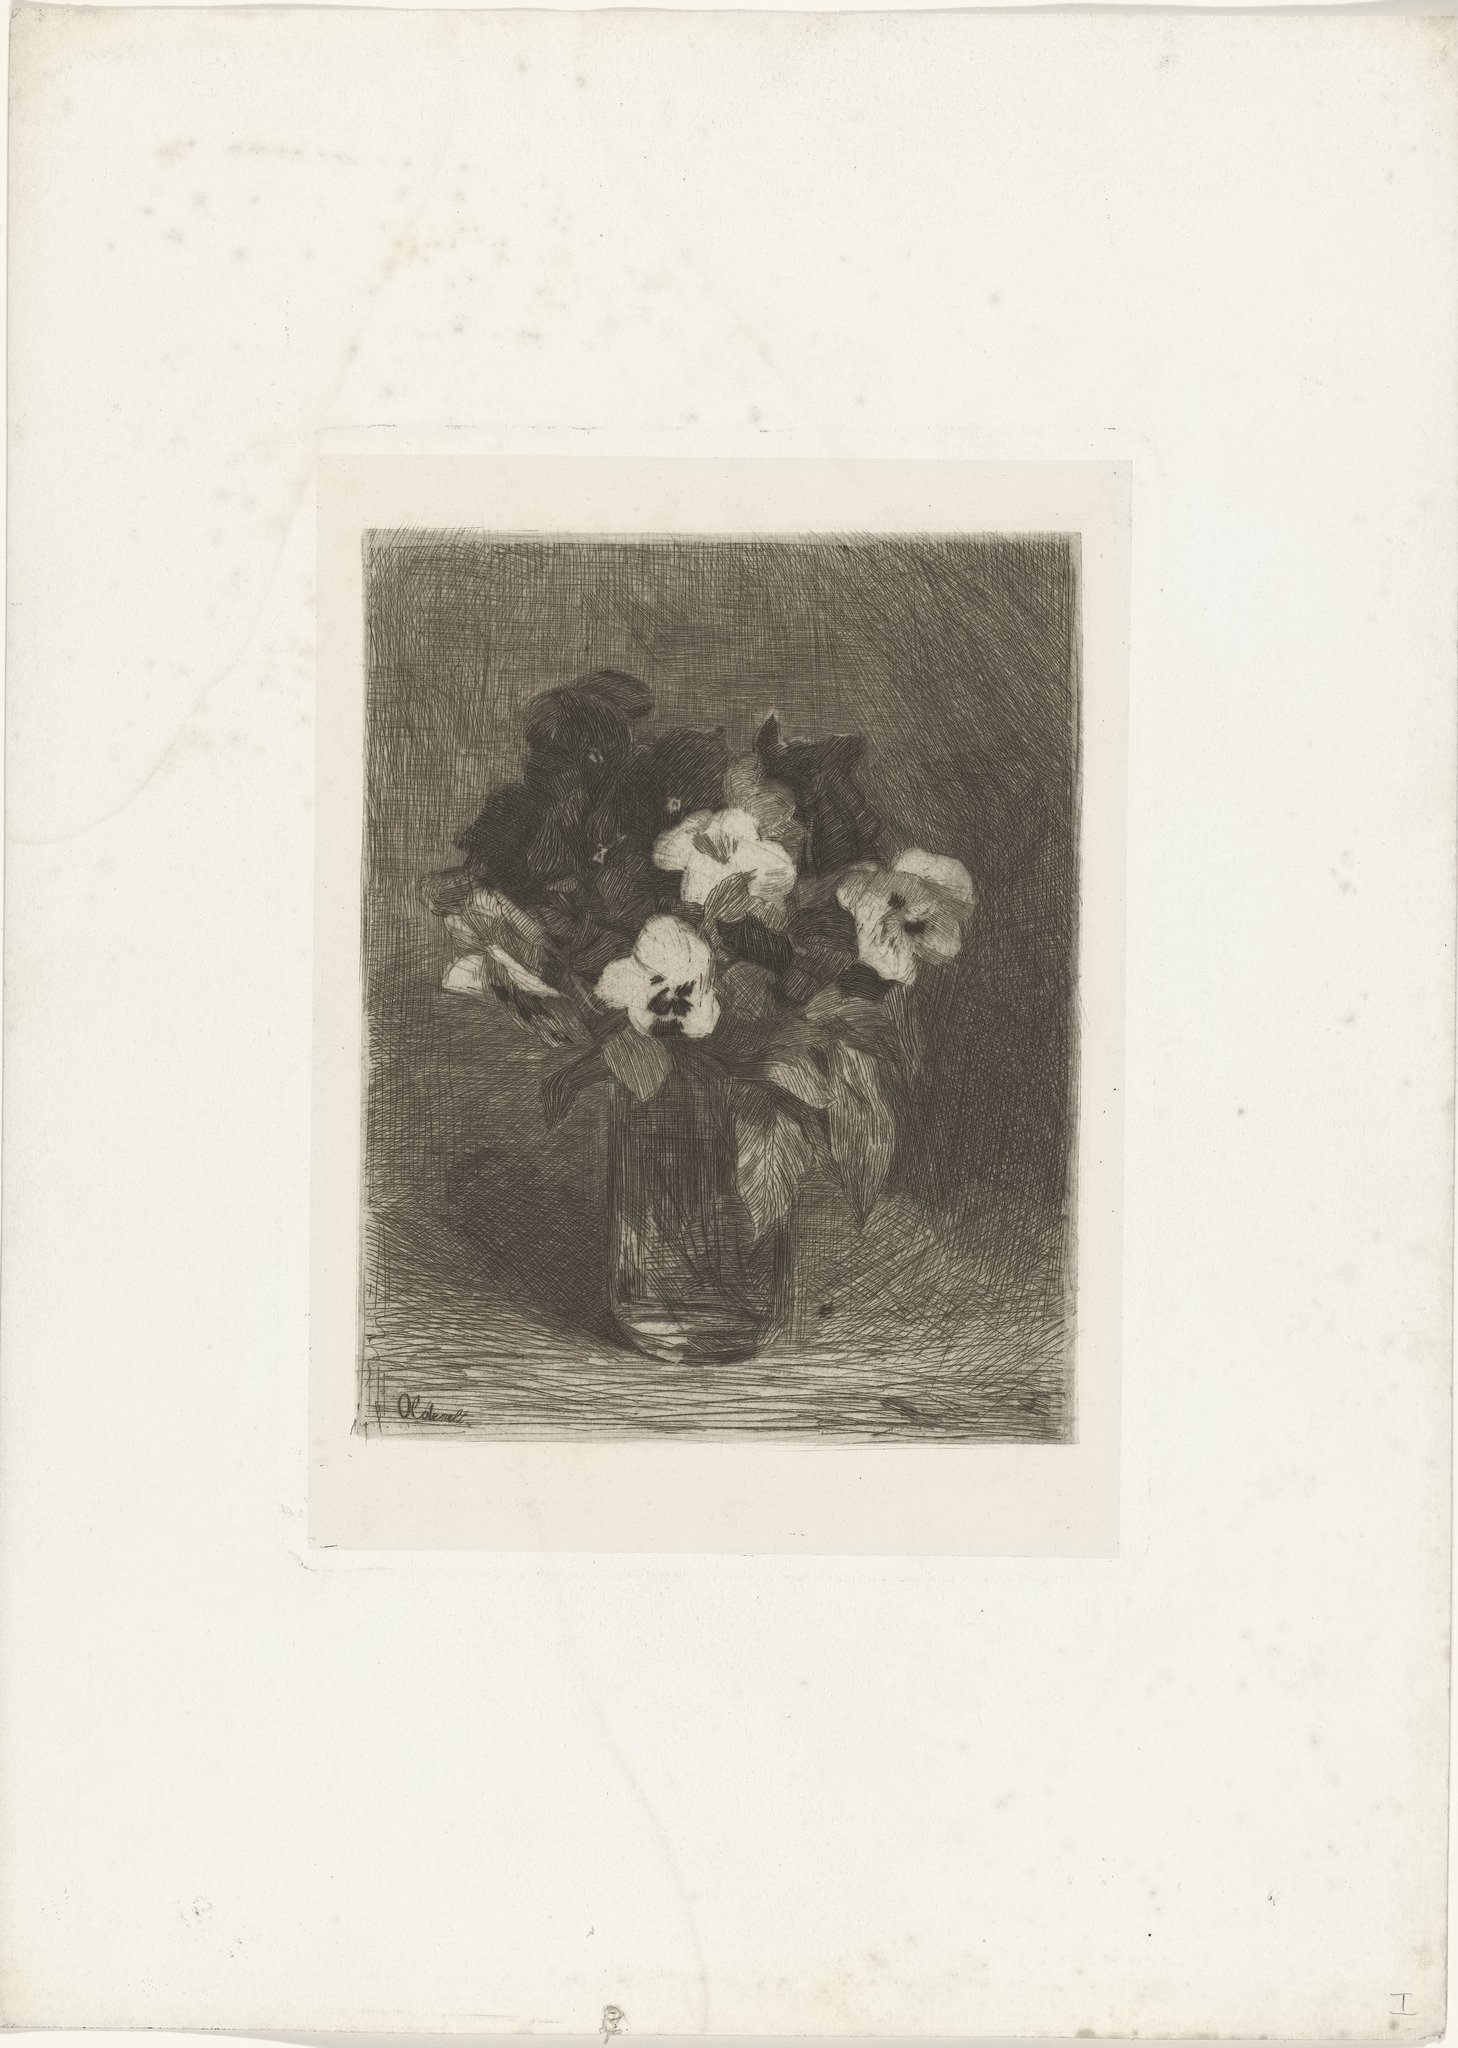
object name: print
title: Viooltjes in een vaas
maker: ferdinand oldewelt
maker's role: draughtsman, print maker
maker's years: 1857-1935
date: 1872-1935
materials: paper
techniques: engraving, etching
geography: netherlands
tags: cut flowers; nosegay, bunch of flowers, flowers: violet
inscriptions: collector's mark: Lugt 2228